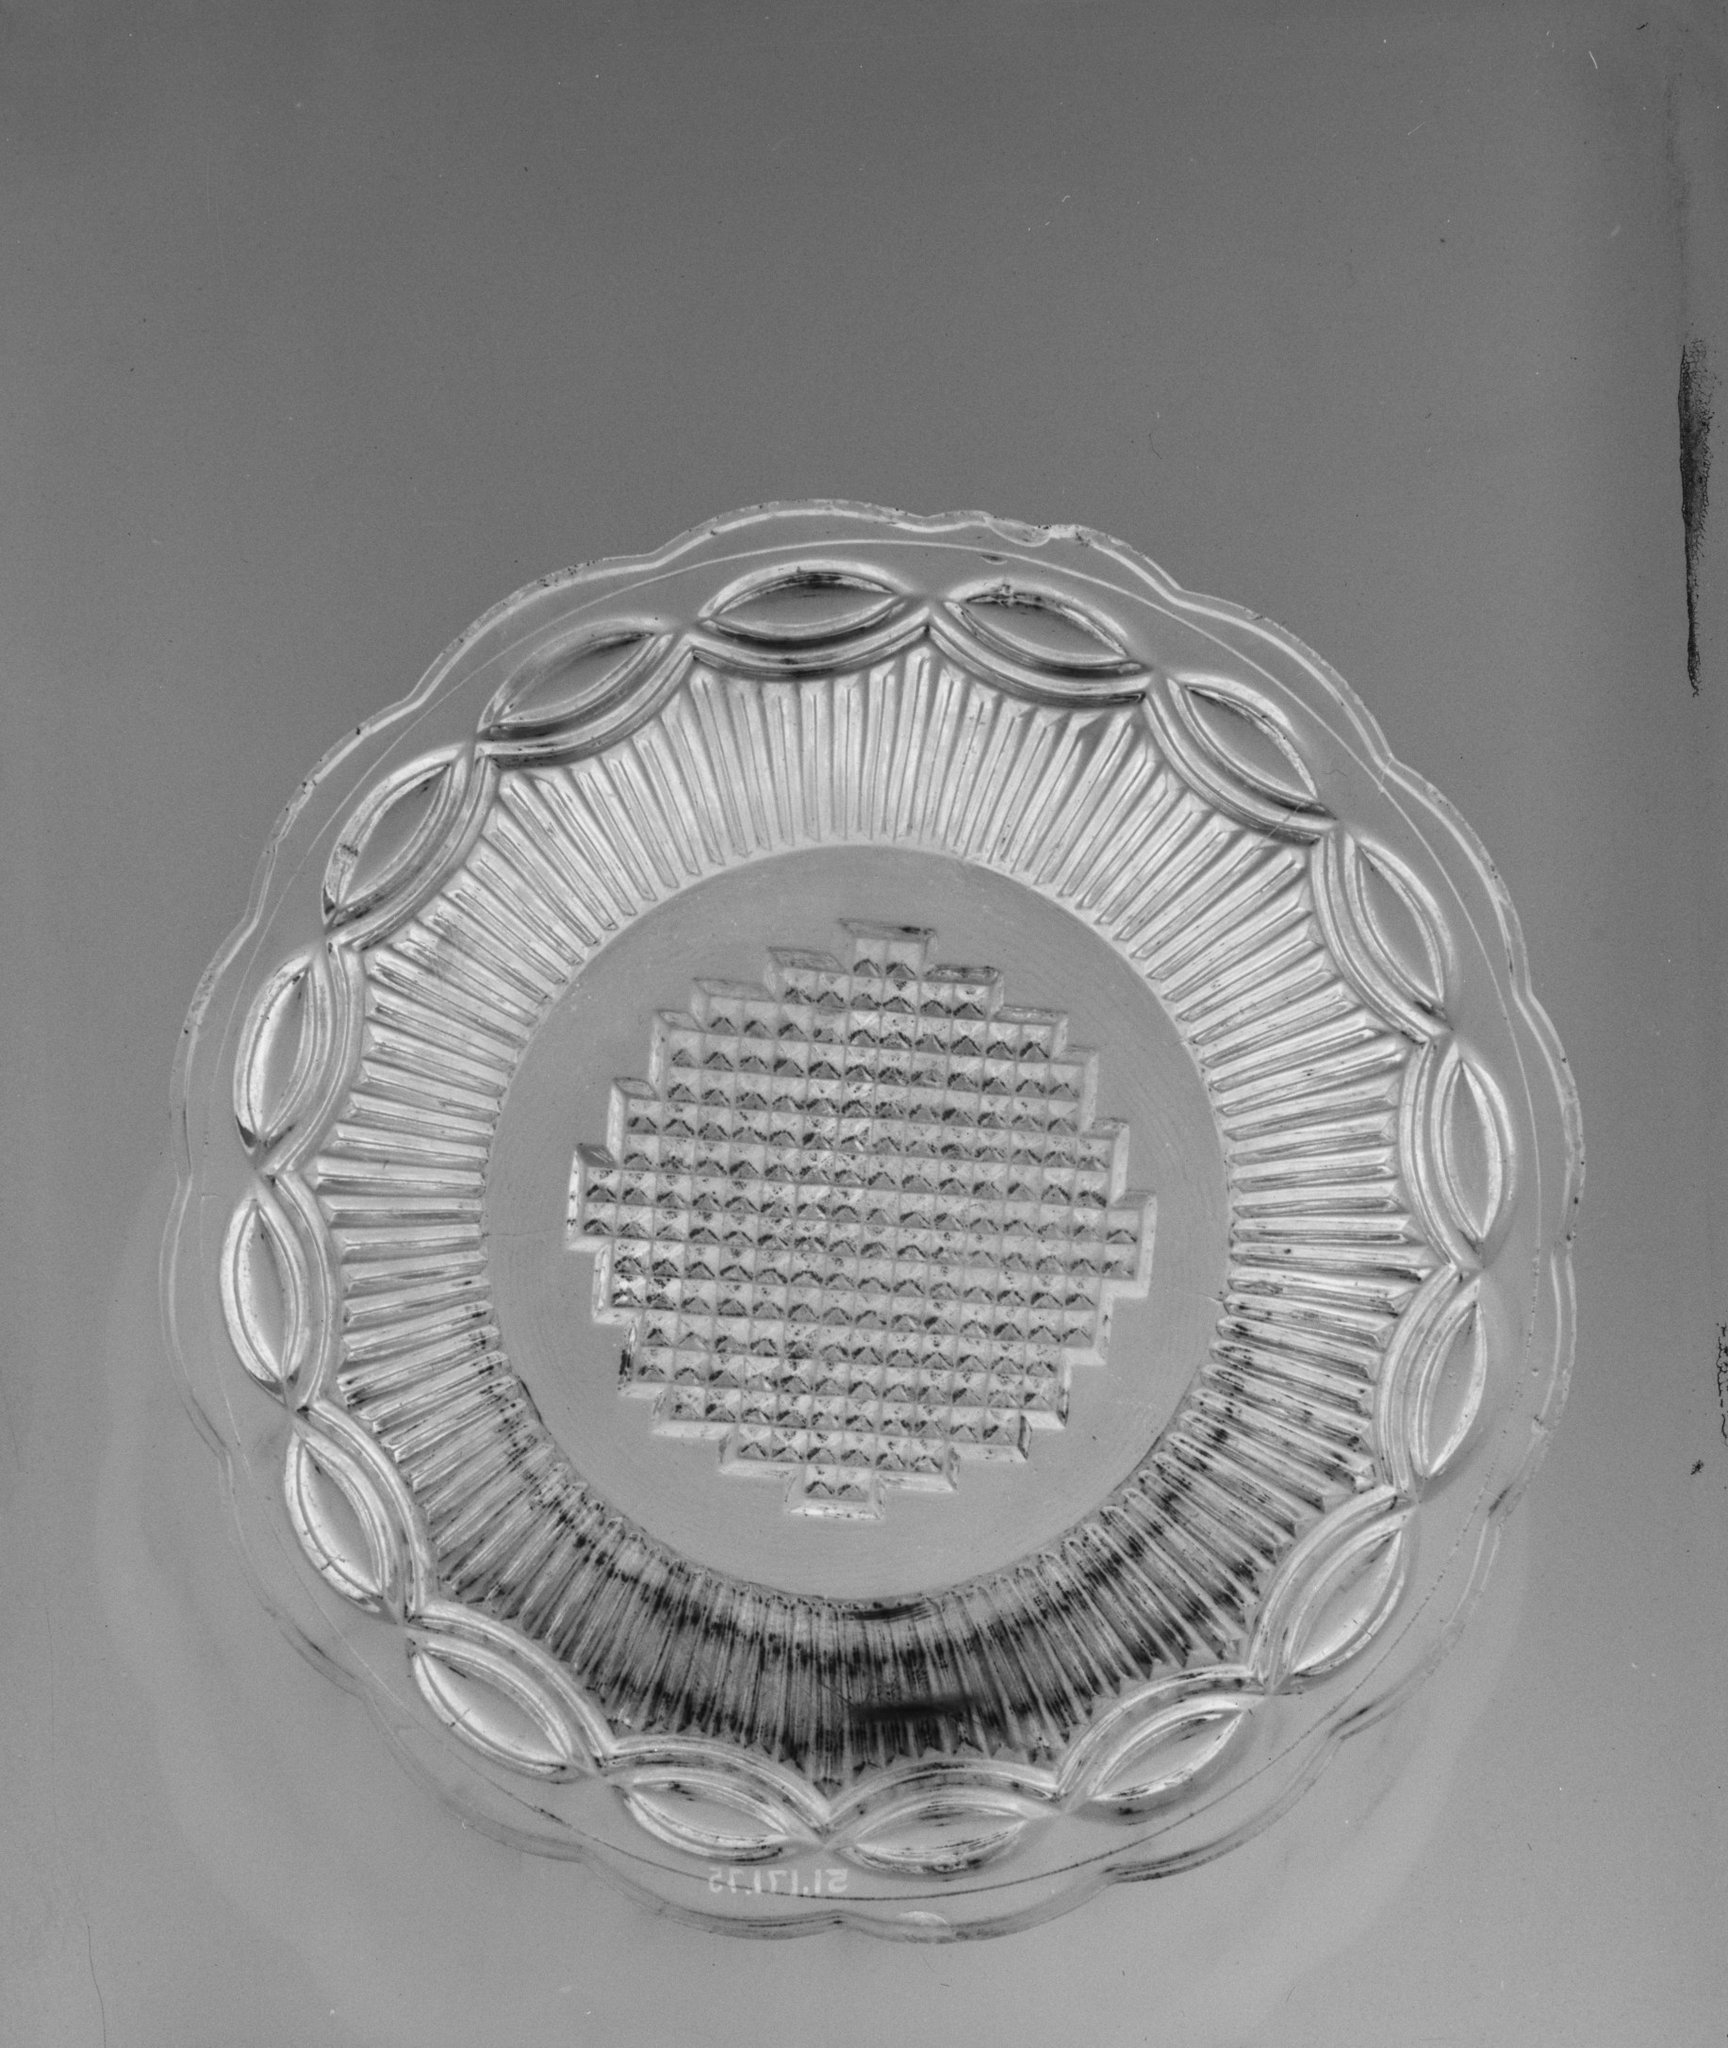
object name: plate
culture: american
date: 1830-1835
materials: glass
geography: united states